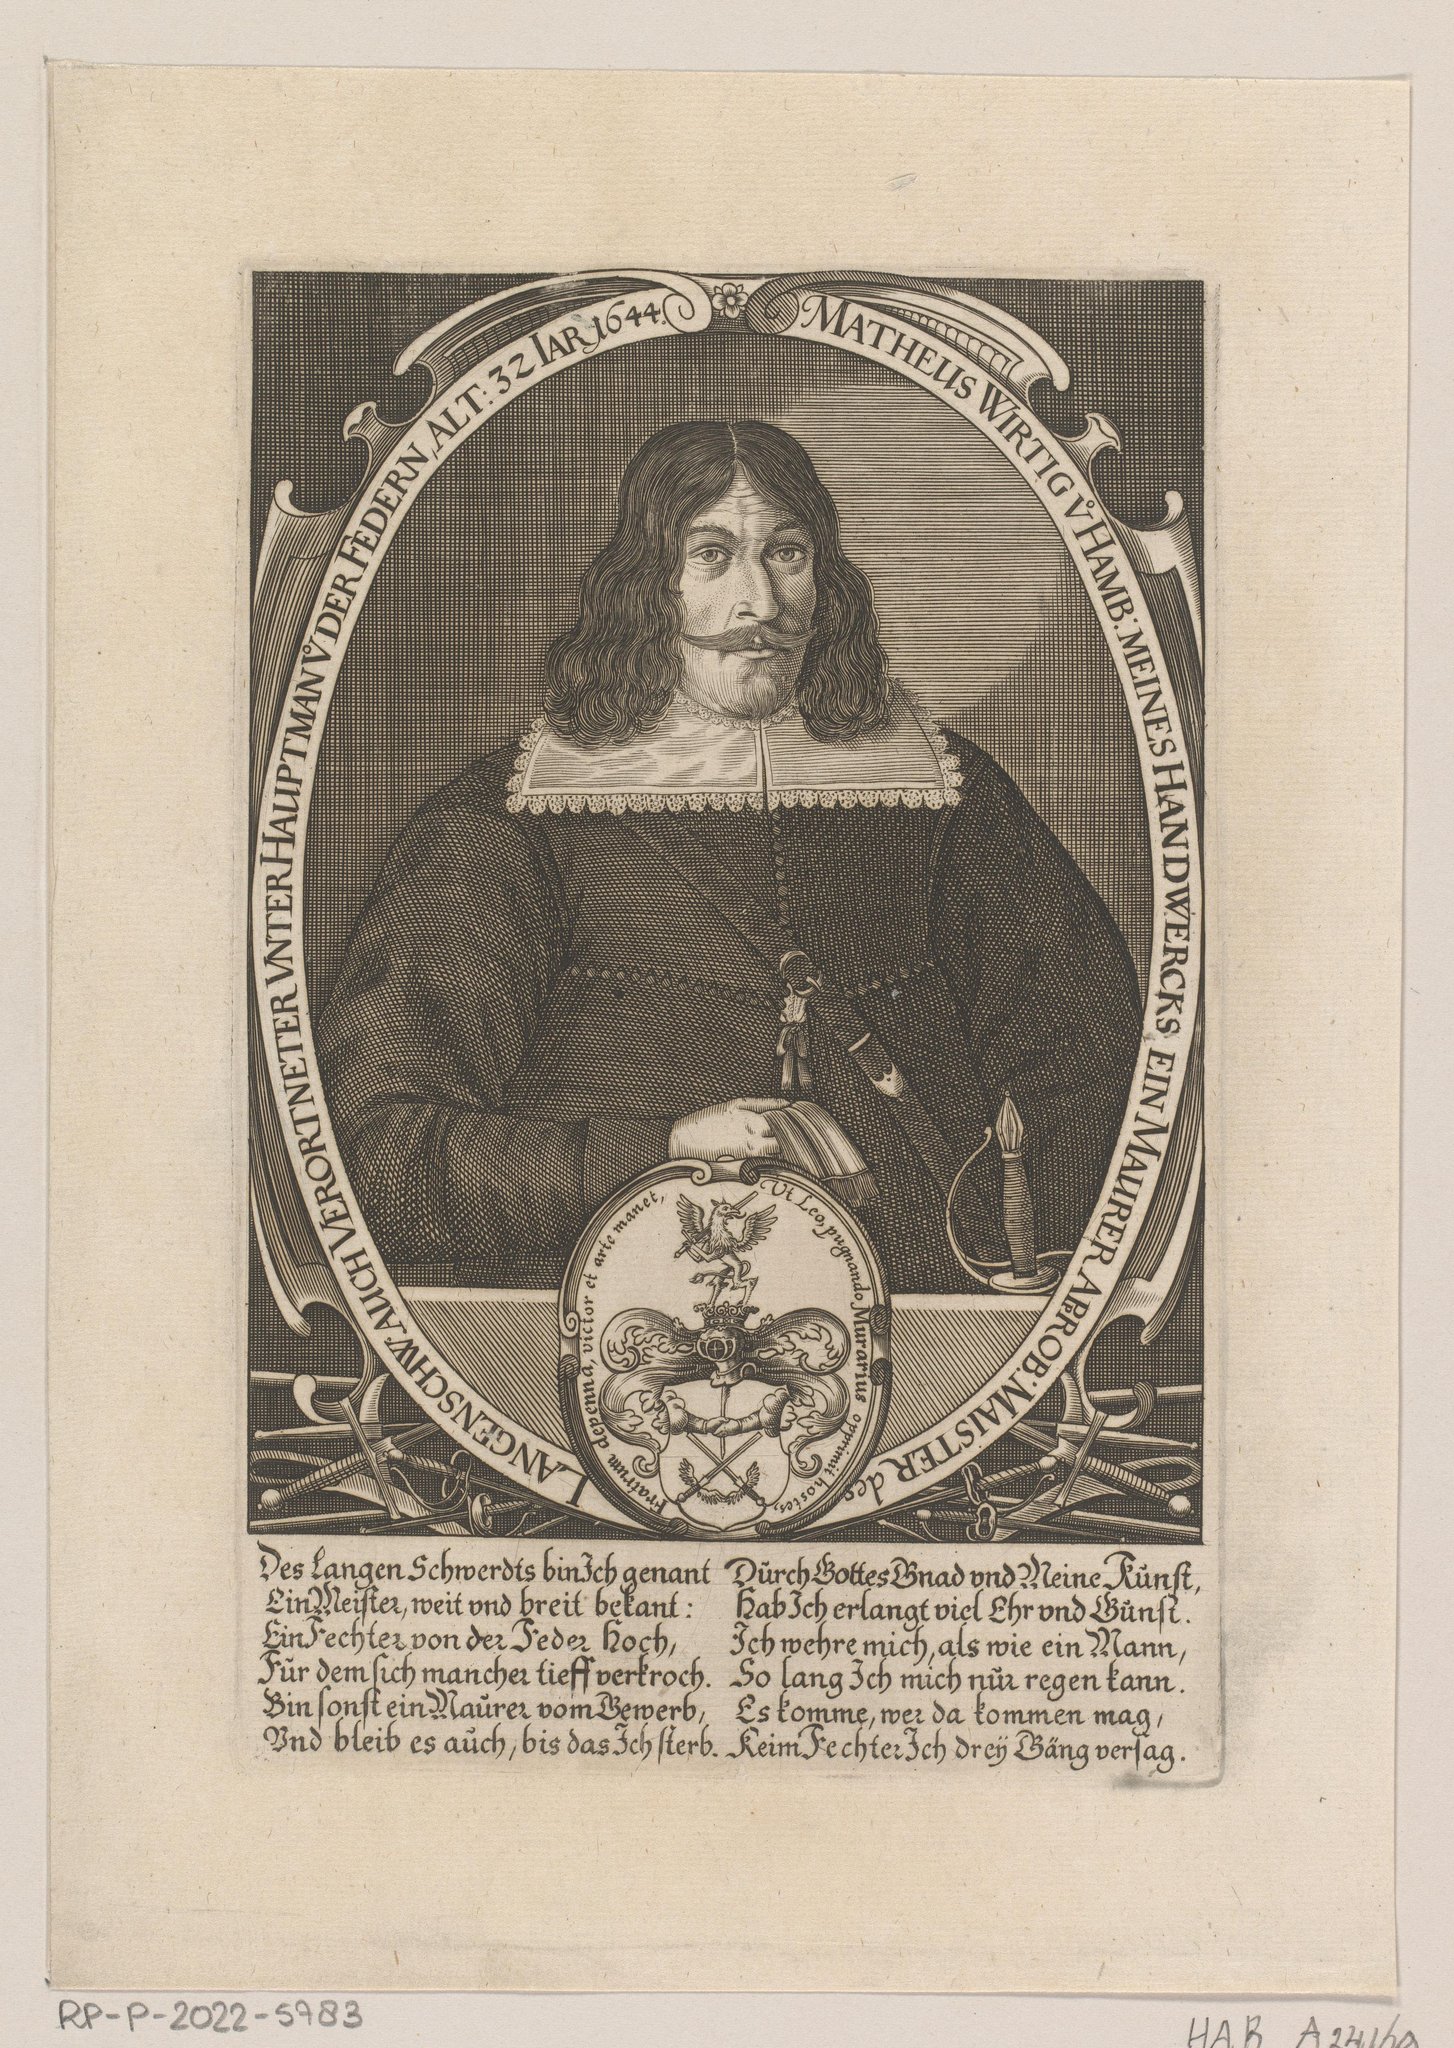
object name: print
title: Portret van Matthäus Wirtig op 32-jarige leeftijd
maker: Anonymous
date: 1644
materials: paper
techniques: engraving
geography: germany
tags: stone-cutter, stone-sawyer, historical persons, armorial bearing, heraldry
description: Met twaalfregelig onderschrift in twee kolommen in het Duits, tekst in het Duits rondom het portret en tekst in het Latijn rondom het wapenschild.